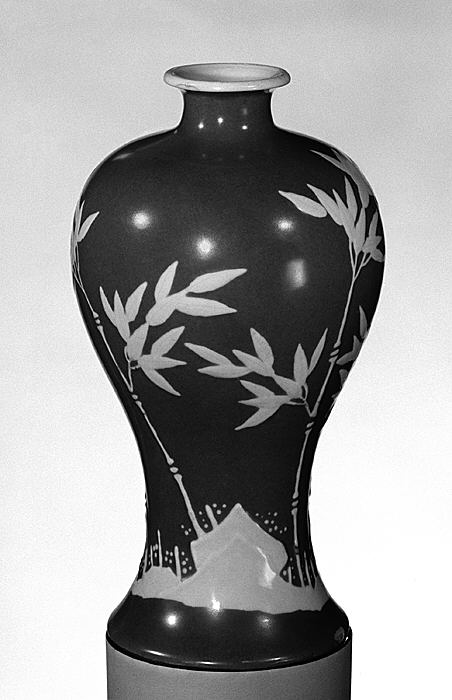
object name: vase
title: Meiping (Plum) Vase with Bamboo and Rocks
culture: chinese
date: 1701-1750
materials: glaze, porcelain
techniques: relief